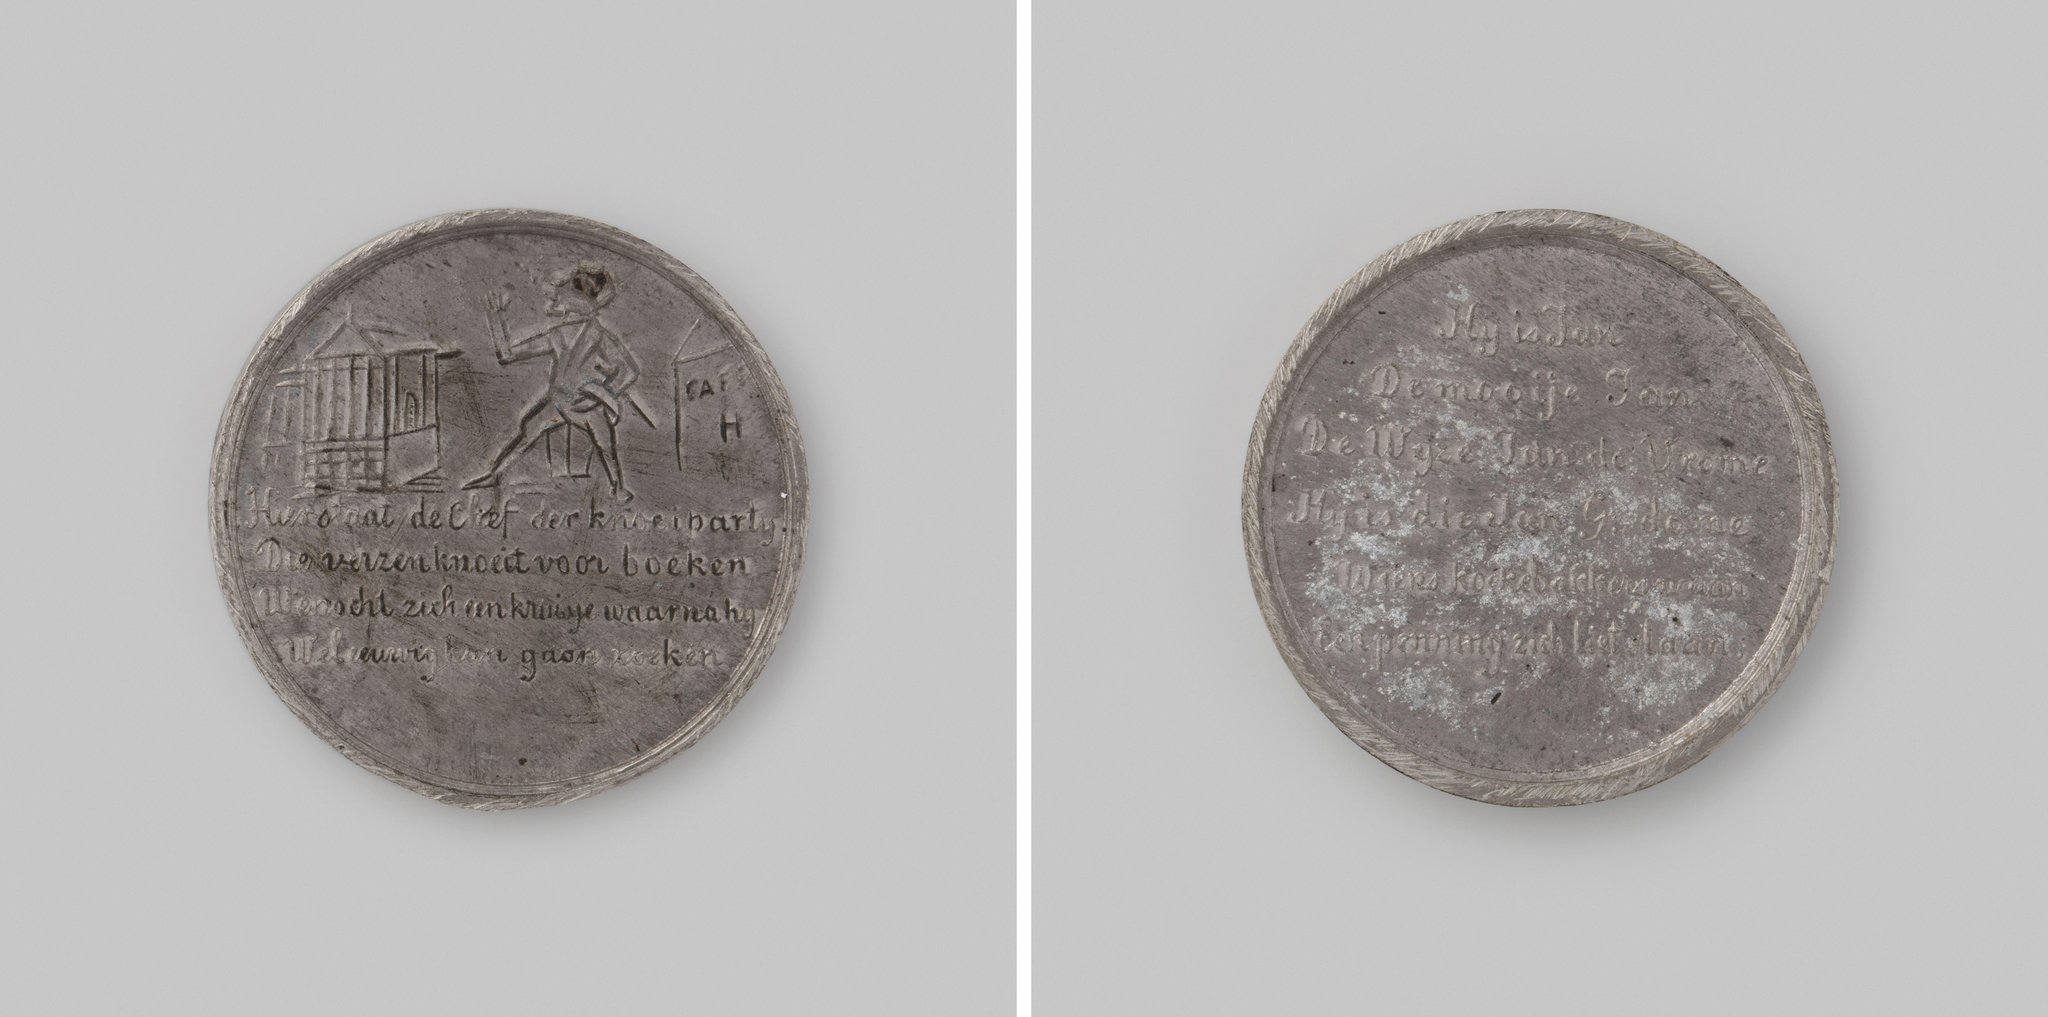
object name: history medal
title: Spotpenning op J. Hilman bij de verbouwing van de Stadsschouwburg te Amsterdam 1873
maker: van maarsseveen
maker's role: factory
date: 1873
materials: tin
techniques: striking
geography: amsterdam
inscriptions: inscription: ‘Hier staat de Chef der knoeipartij / Die verzen knoeit voor boeken / Wenscht zich een kruisje waarna hij / Wel eeuwig kan gaan zoeken’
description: Tinnen penning, op de voorzijde een lijntekening van een heer met sigaar in bewondering voor een gebouw, met vier regels tekst, op de keerzijde zes regels tekst.